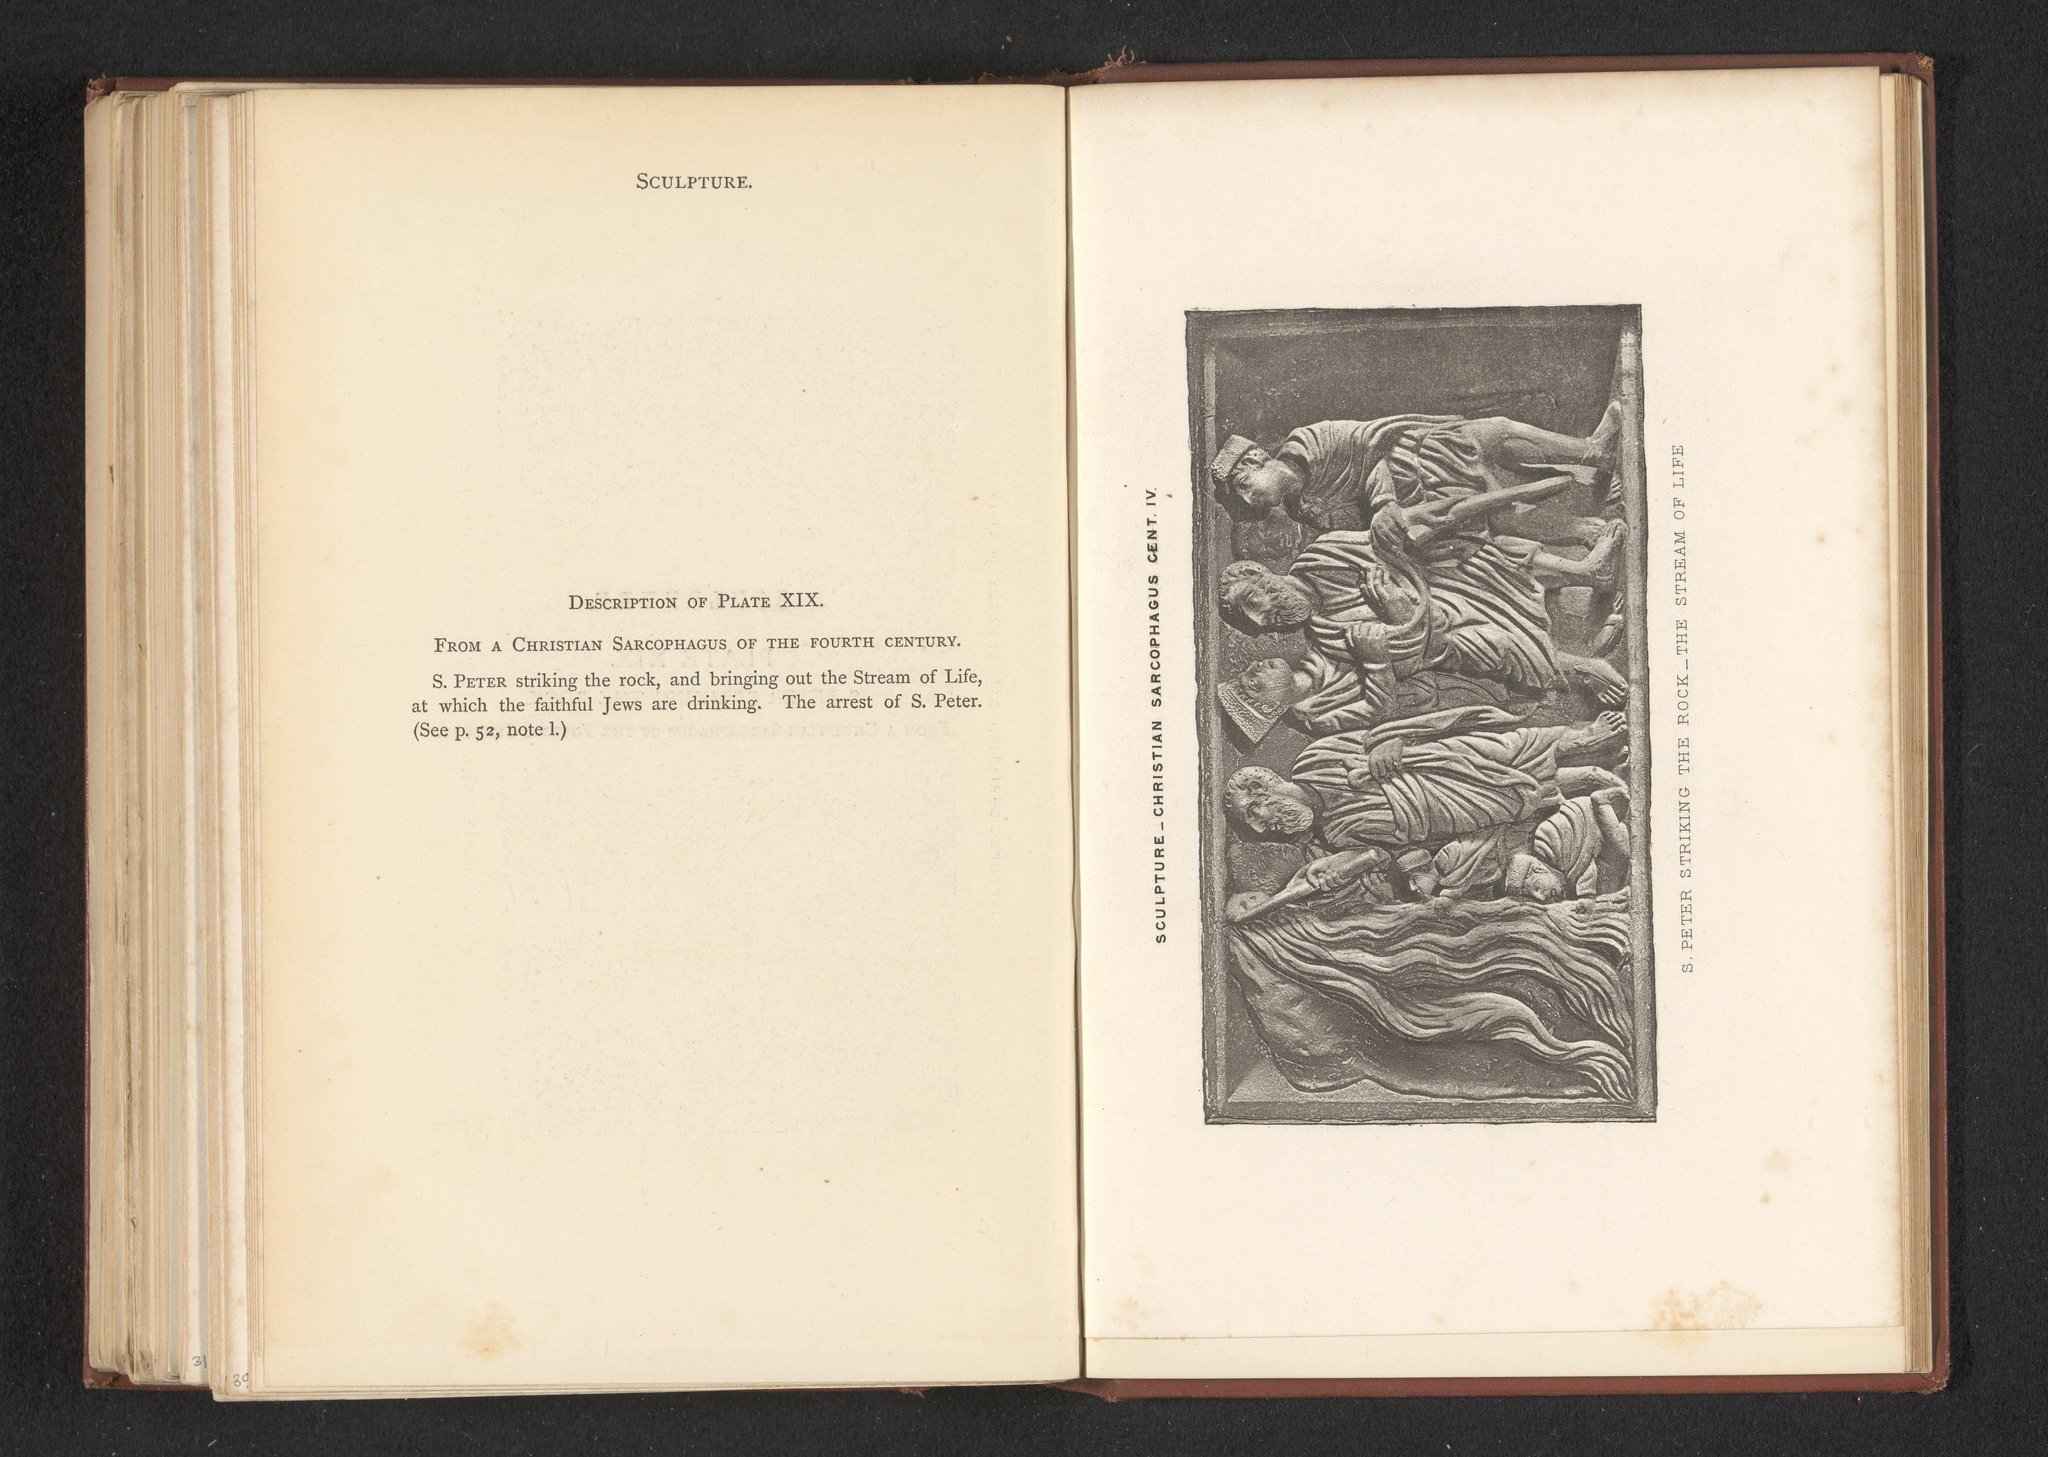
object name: page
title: Sculpture - Christian sarcophagus cent. IV.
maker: Anonymous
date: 1867-1877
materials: paper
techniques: photoaquatint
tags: peter in gaol strikes water from a rock and baptizes processus and martinian, the guards, sarcophagus, decorating 'en relief', appliquéing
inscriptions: inscription: ‘S. Peter striking the rock - The stream of life’